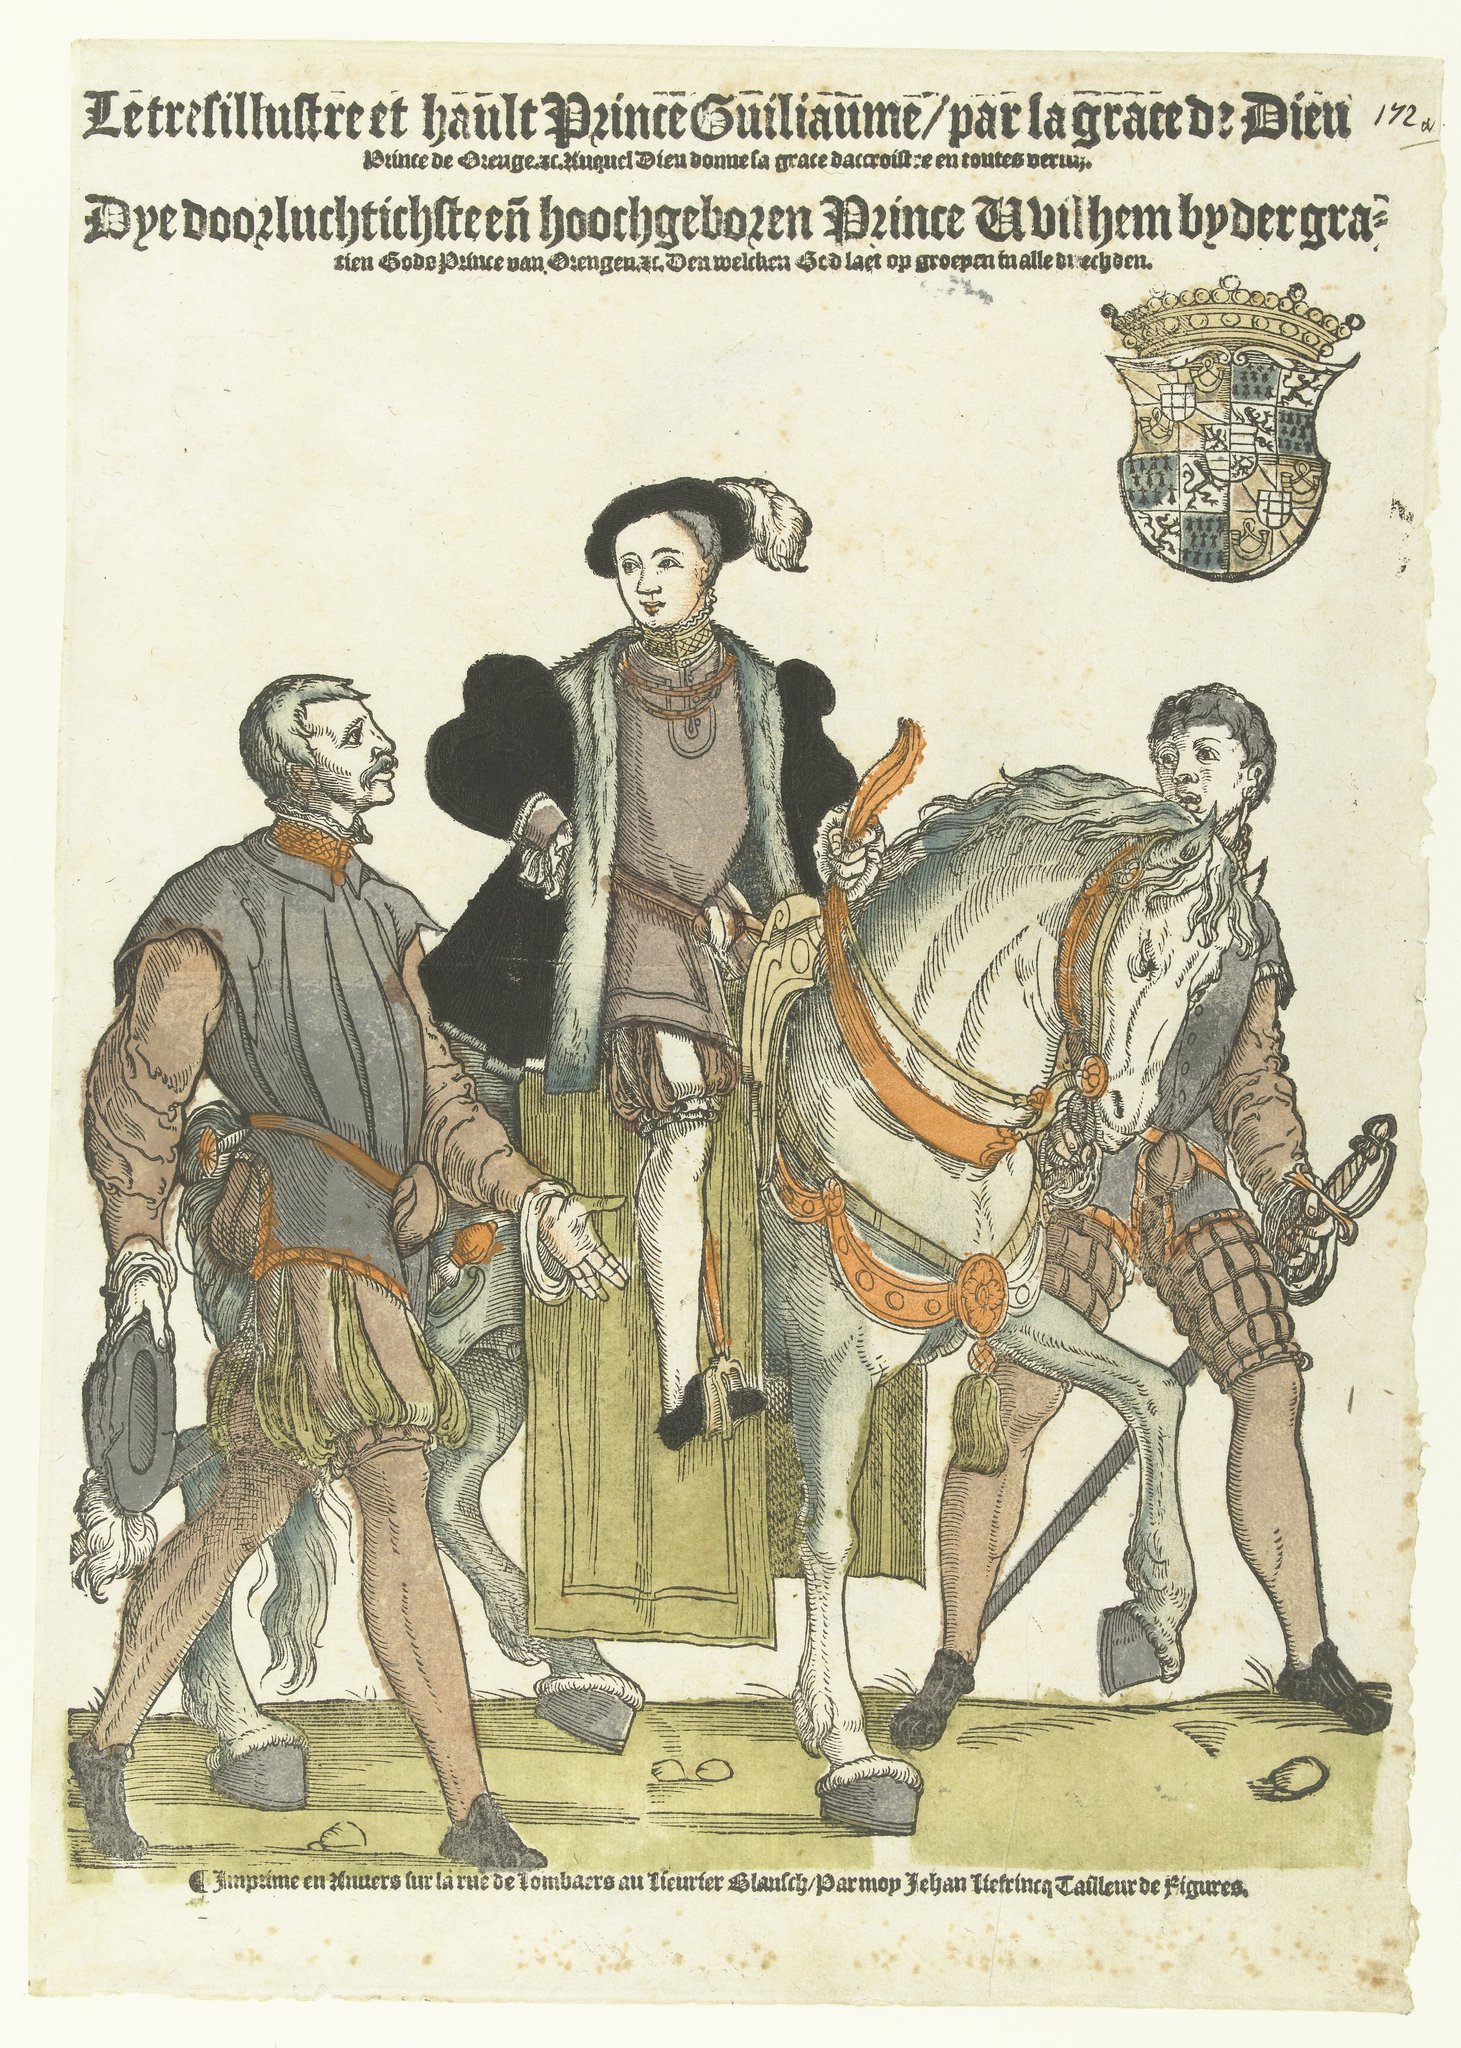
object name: print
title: Portret van Willem van Oranje als jongen te paard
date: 1544-1559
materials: paper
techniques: hand coloring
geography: antwerp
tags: delft, william i (prince of orange), equestrian state-portrait, historical persons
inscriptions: title: ‘Le tres illustre et hault Prince Guiliaume/ par la grace de Dieu....’, address: ‘Imprime en Anvers sur la rue de Lombaers au Lieurter Blansch/ Par moy Jehan Liefrincq Tailleur de Figures.’, number: ‘172a’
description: Willem van Oranje (1533-1584) als jongeman, zittend op een paard. Links en rechts van het paard loopt een voetknecht. Rechtsboven zijn wapen. De prins lijkt niet ouder dan 12 jaar, de leeftijd waarop hij aan het hof in Brussel kwam.